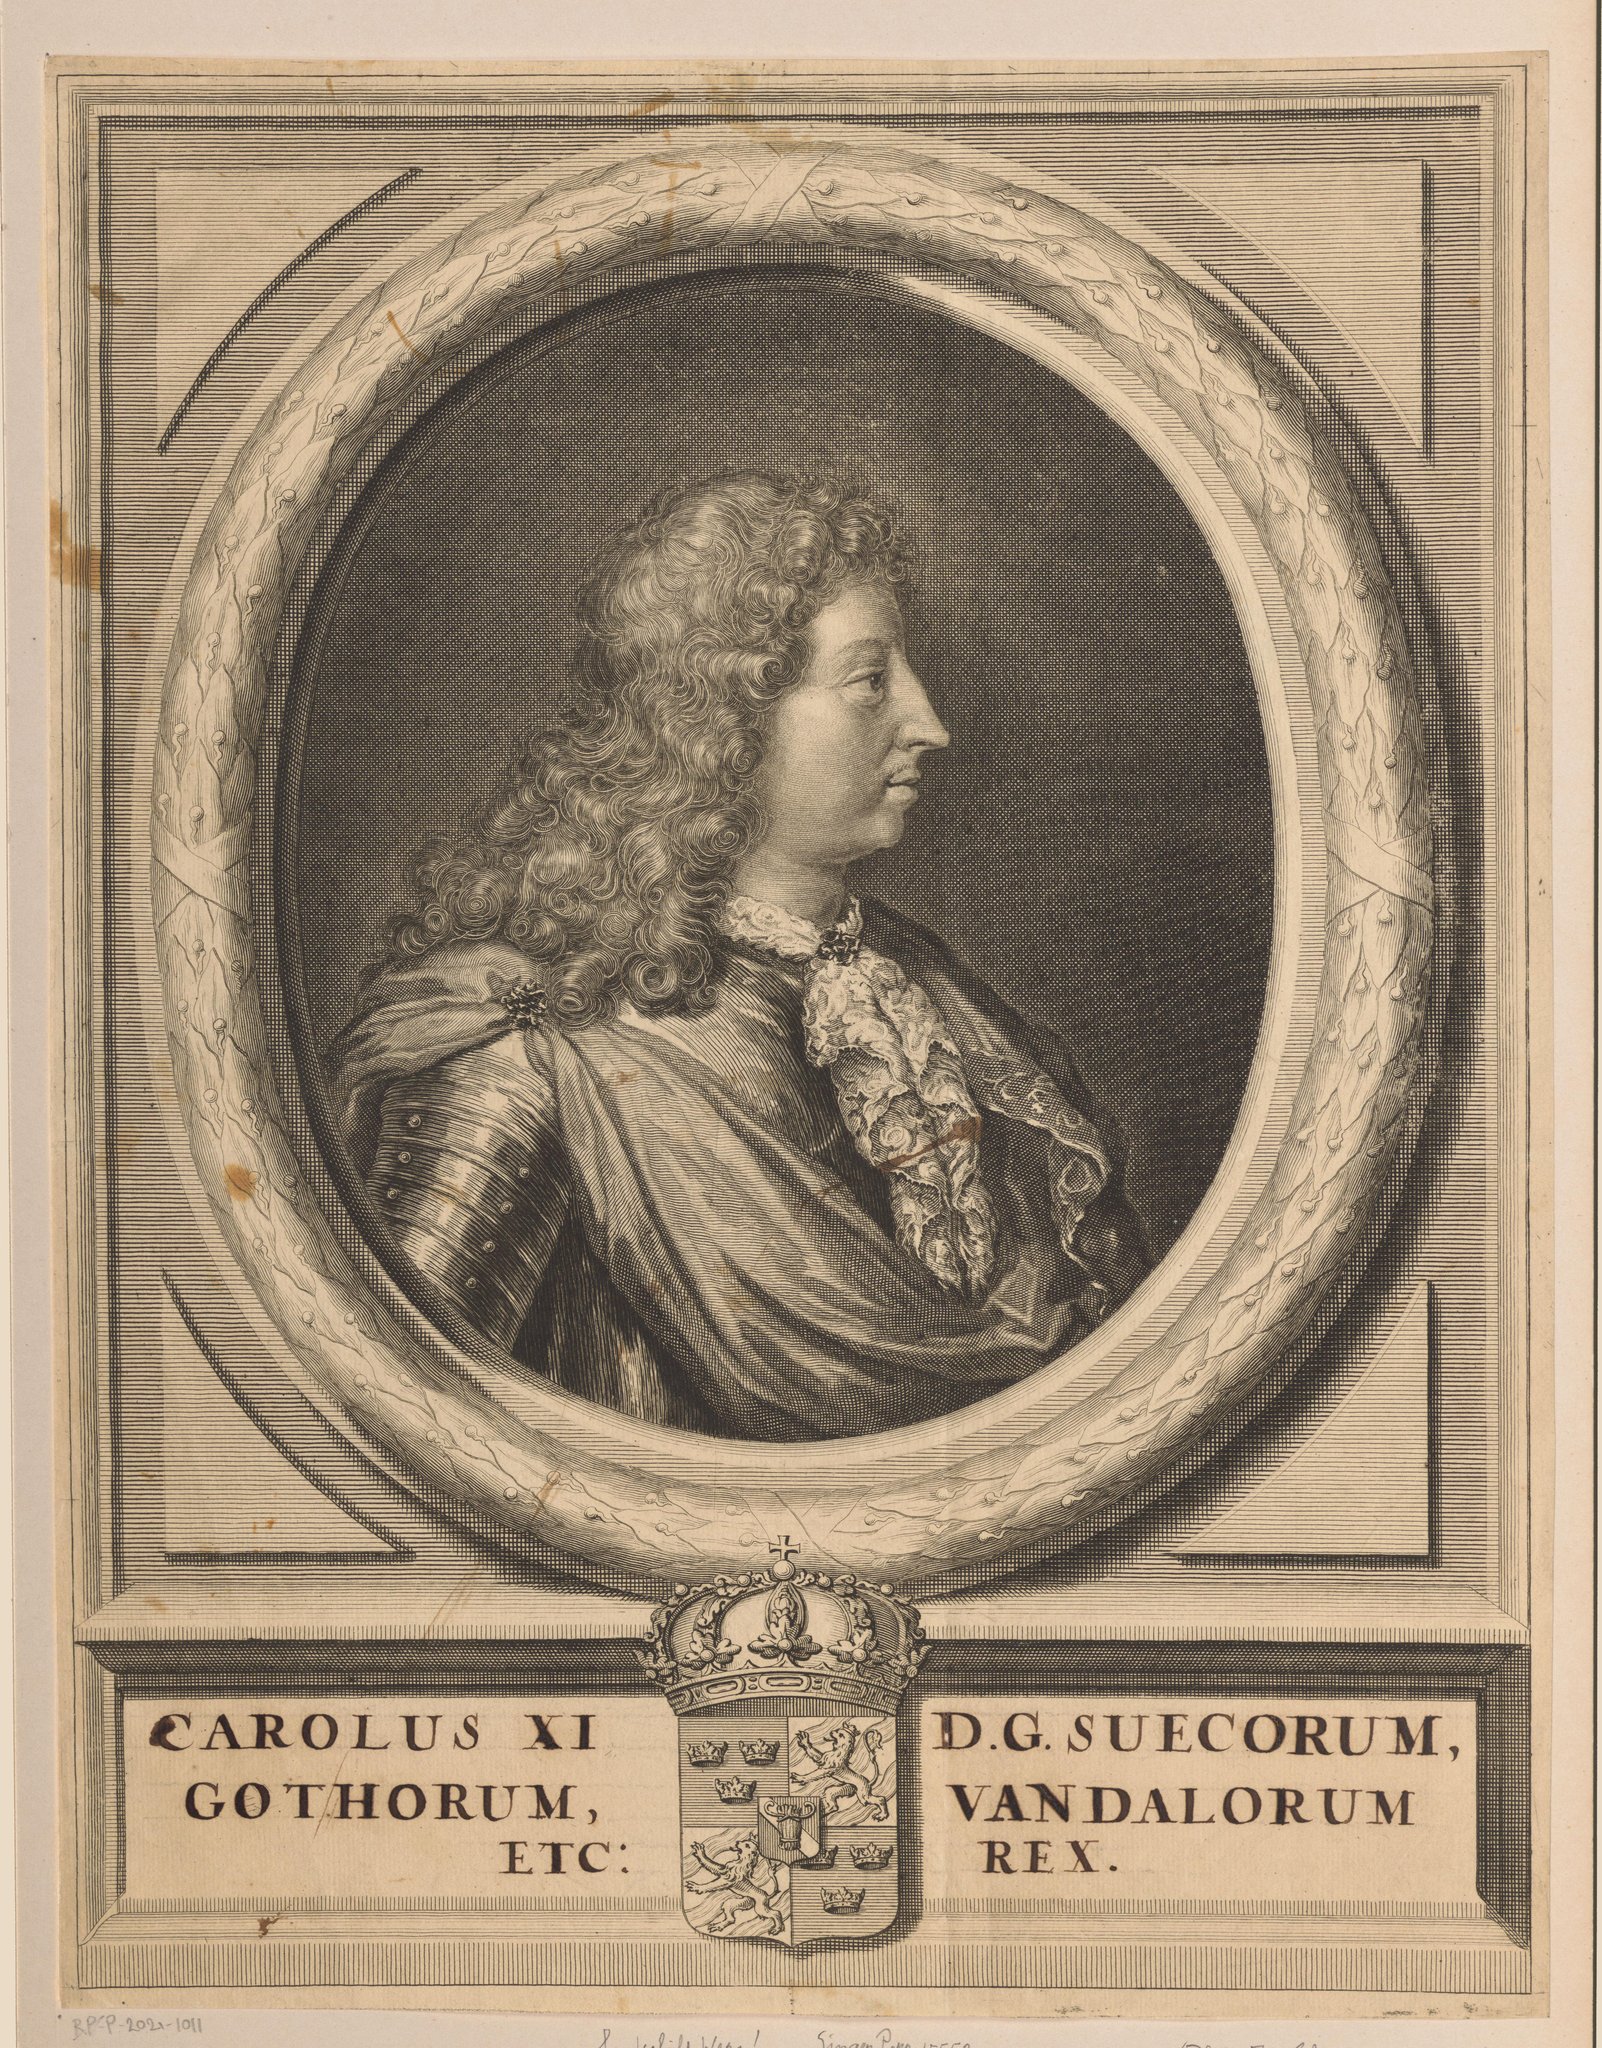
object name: print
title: Portret van Karel XI, koning van Zweden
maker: jacob gole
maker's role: print maker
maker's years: 1660-1724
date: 1685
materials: ink, paper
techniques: engraving, pen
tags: armour, historical persons, king, armorial bearing, heraldry